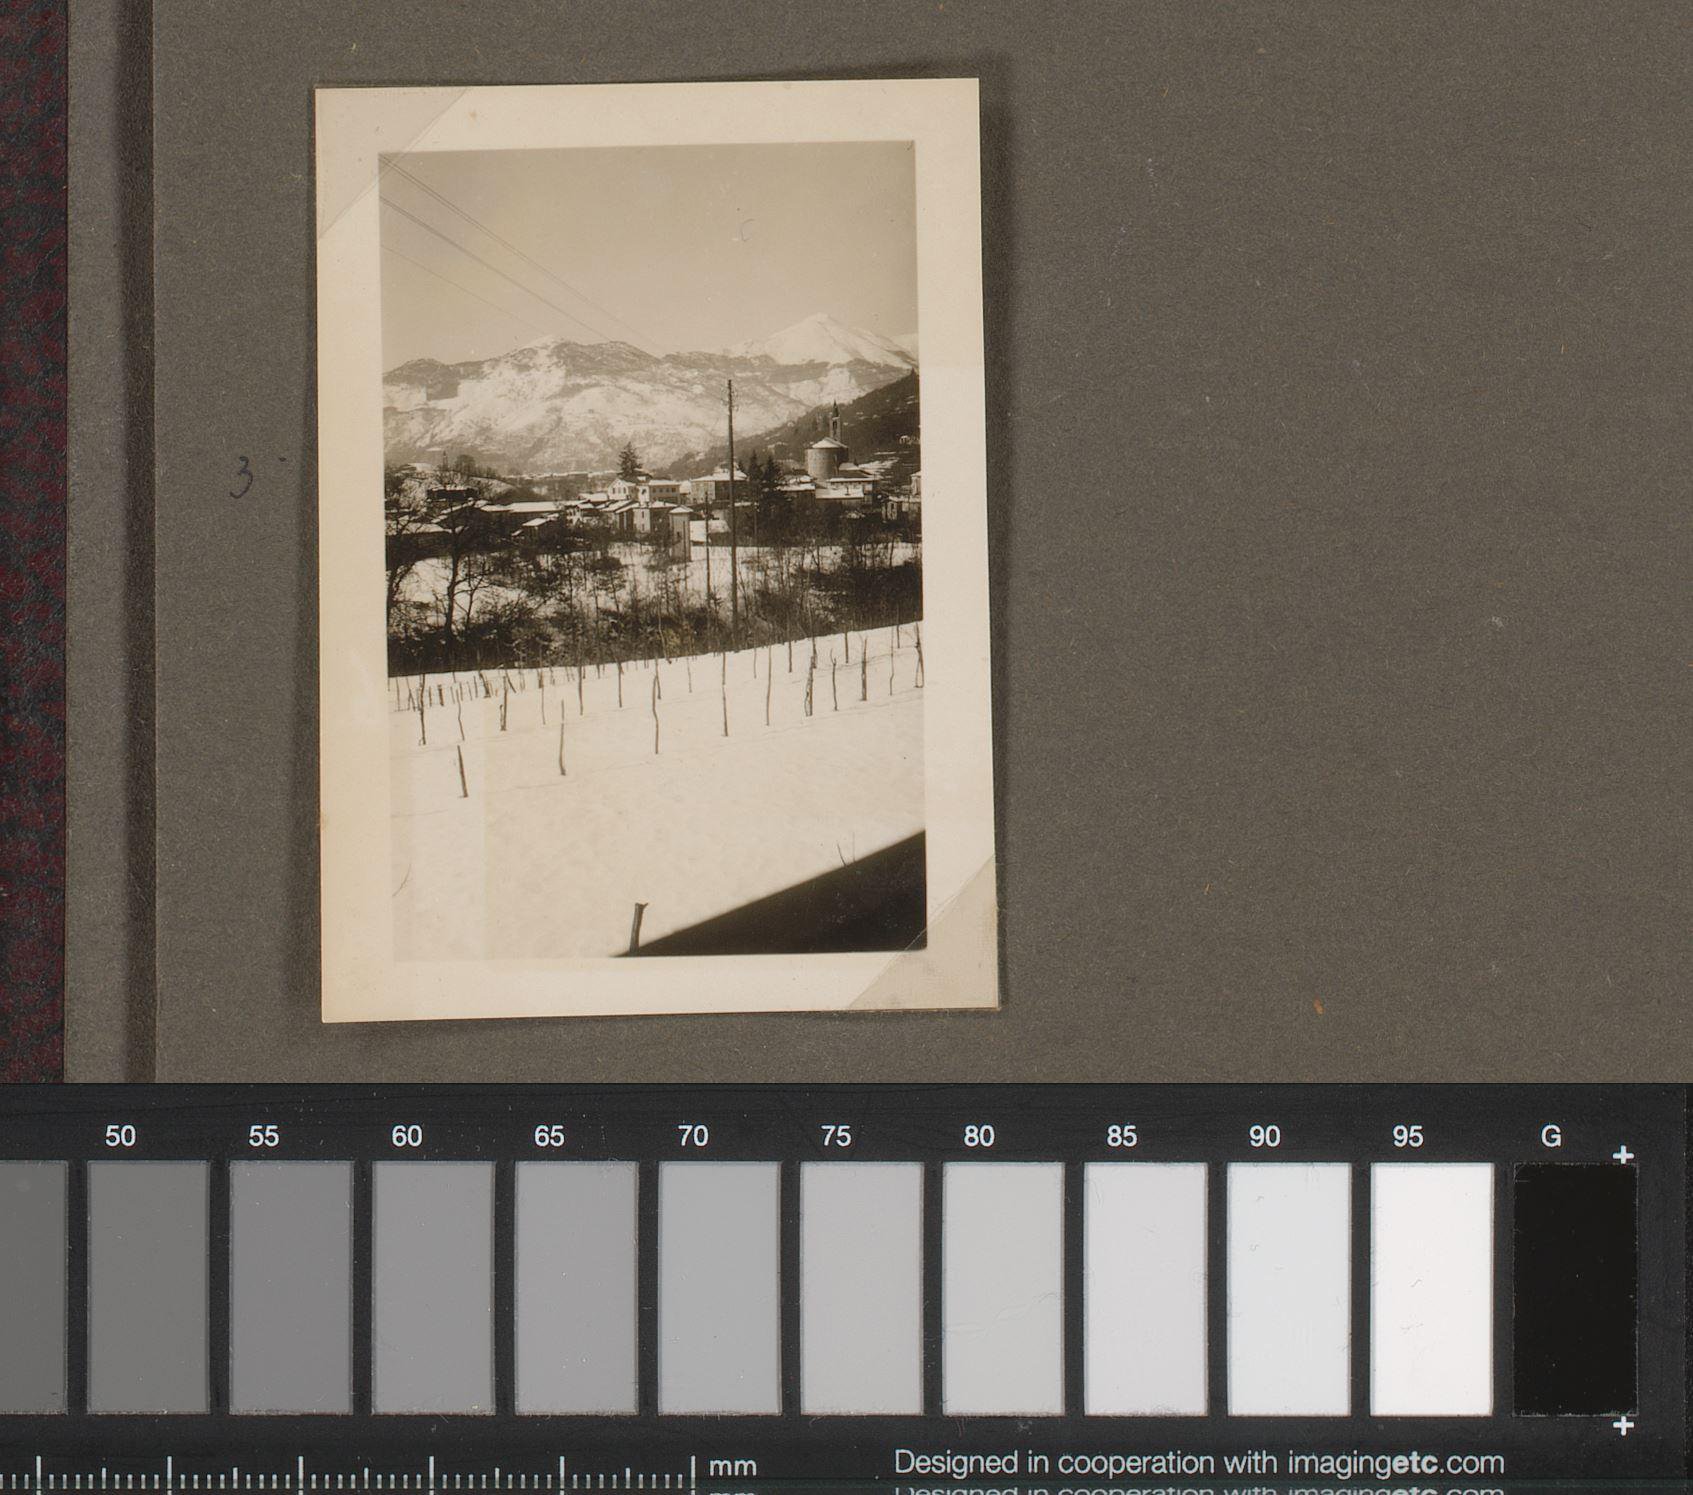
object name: photograph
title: Op weg naar het kasteel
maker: Anonymous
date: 1933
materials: photographic support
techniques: gelatin silver print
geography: tesserete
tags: landscape with tower or castle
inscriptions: number: ‘3’